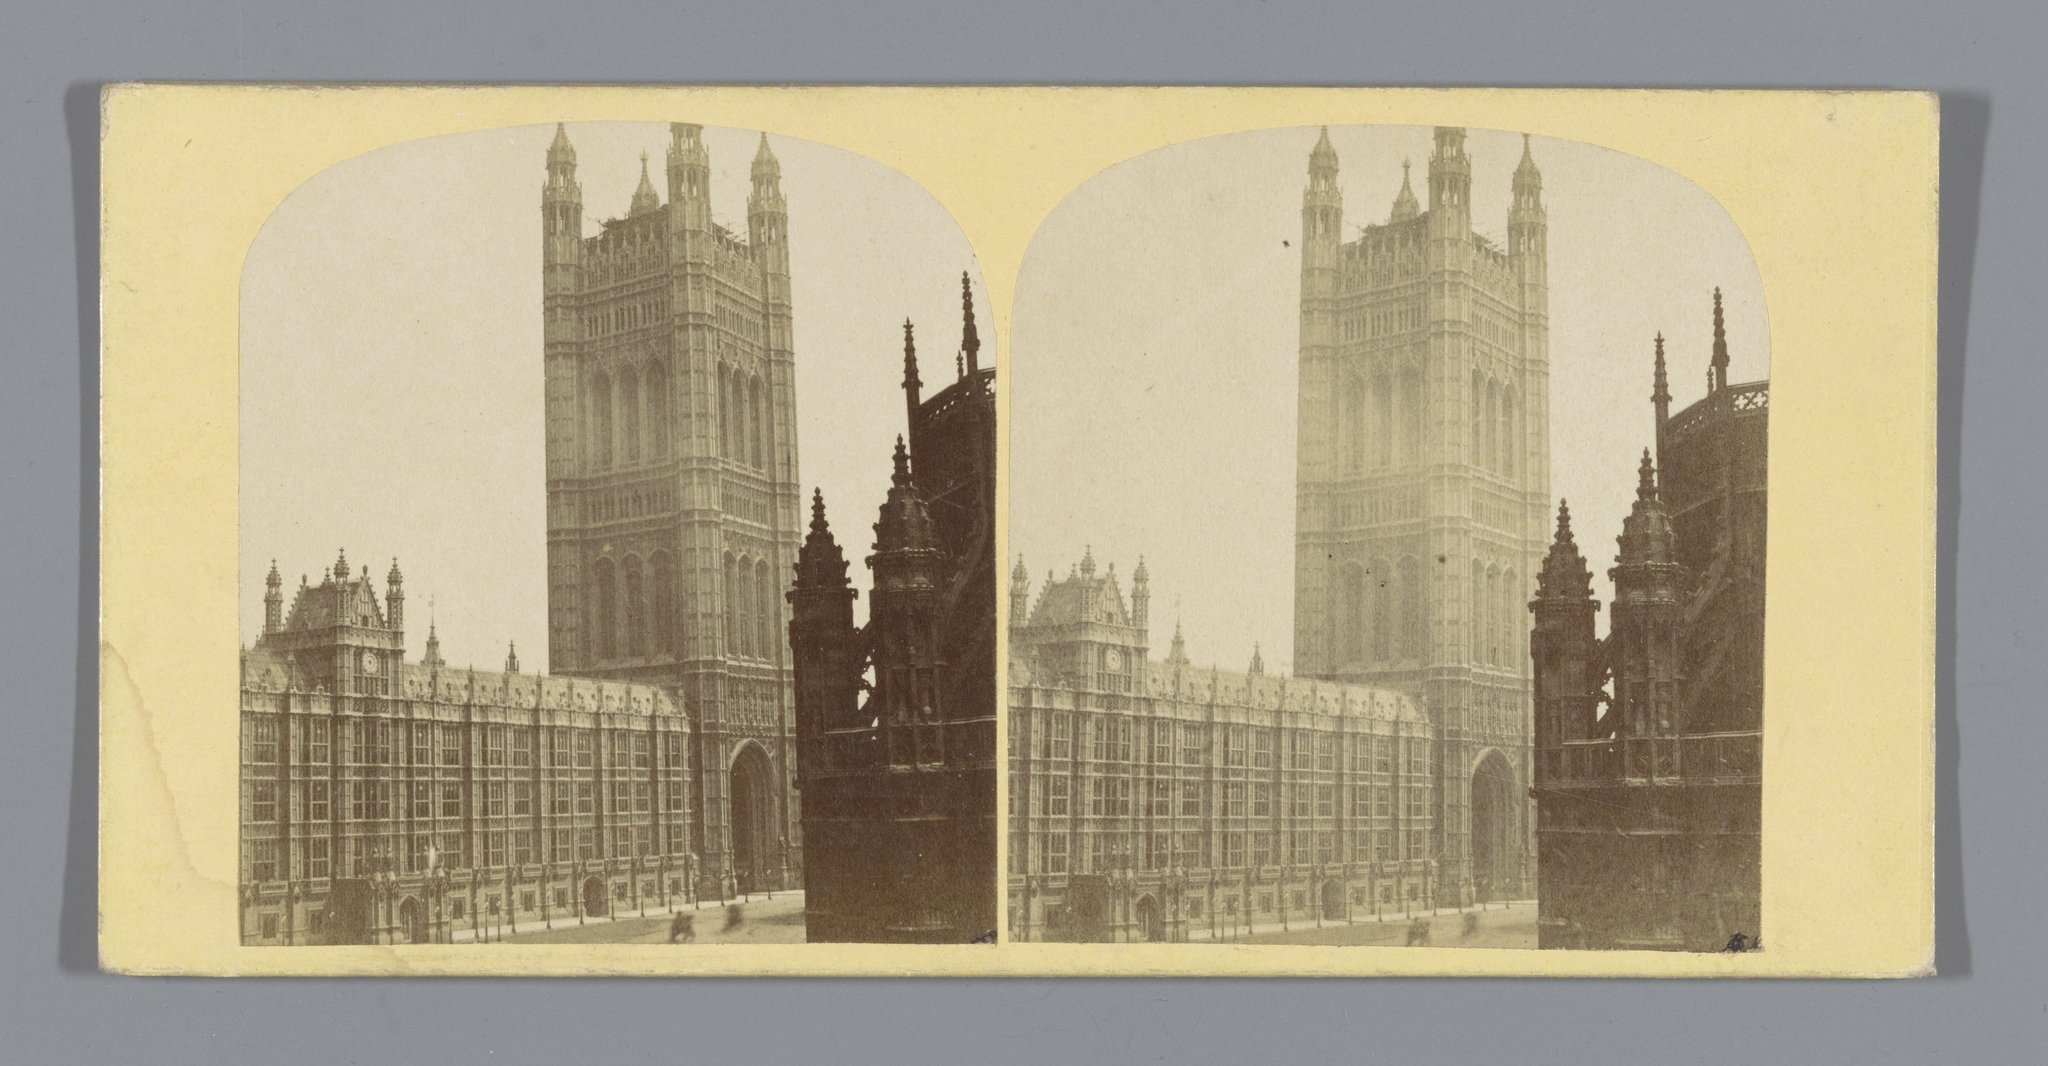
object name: stereograph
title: Gezicht op de Victoria Tower te Londen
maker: james elliott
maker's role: publisher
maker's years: 1832-1900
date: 1850-1880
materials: cardboard, photographic support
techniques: albumen print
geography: london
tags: tower, clock tower ~ monumental adornment, lower house, parliament, chamber